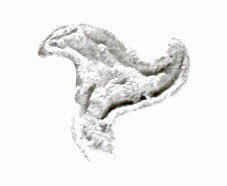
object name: stamp seal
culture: bactria-margiana archaeological complex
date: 2333-1668 BCE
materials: copper alloy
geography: bactria-margiana